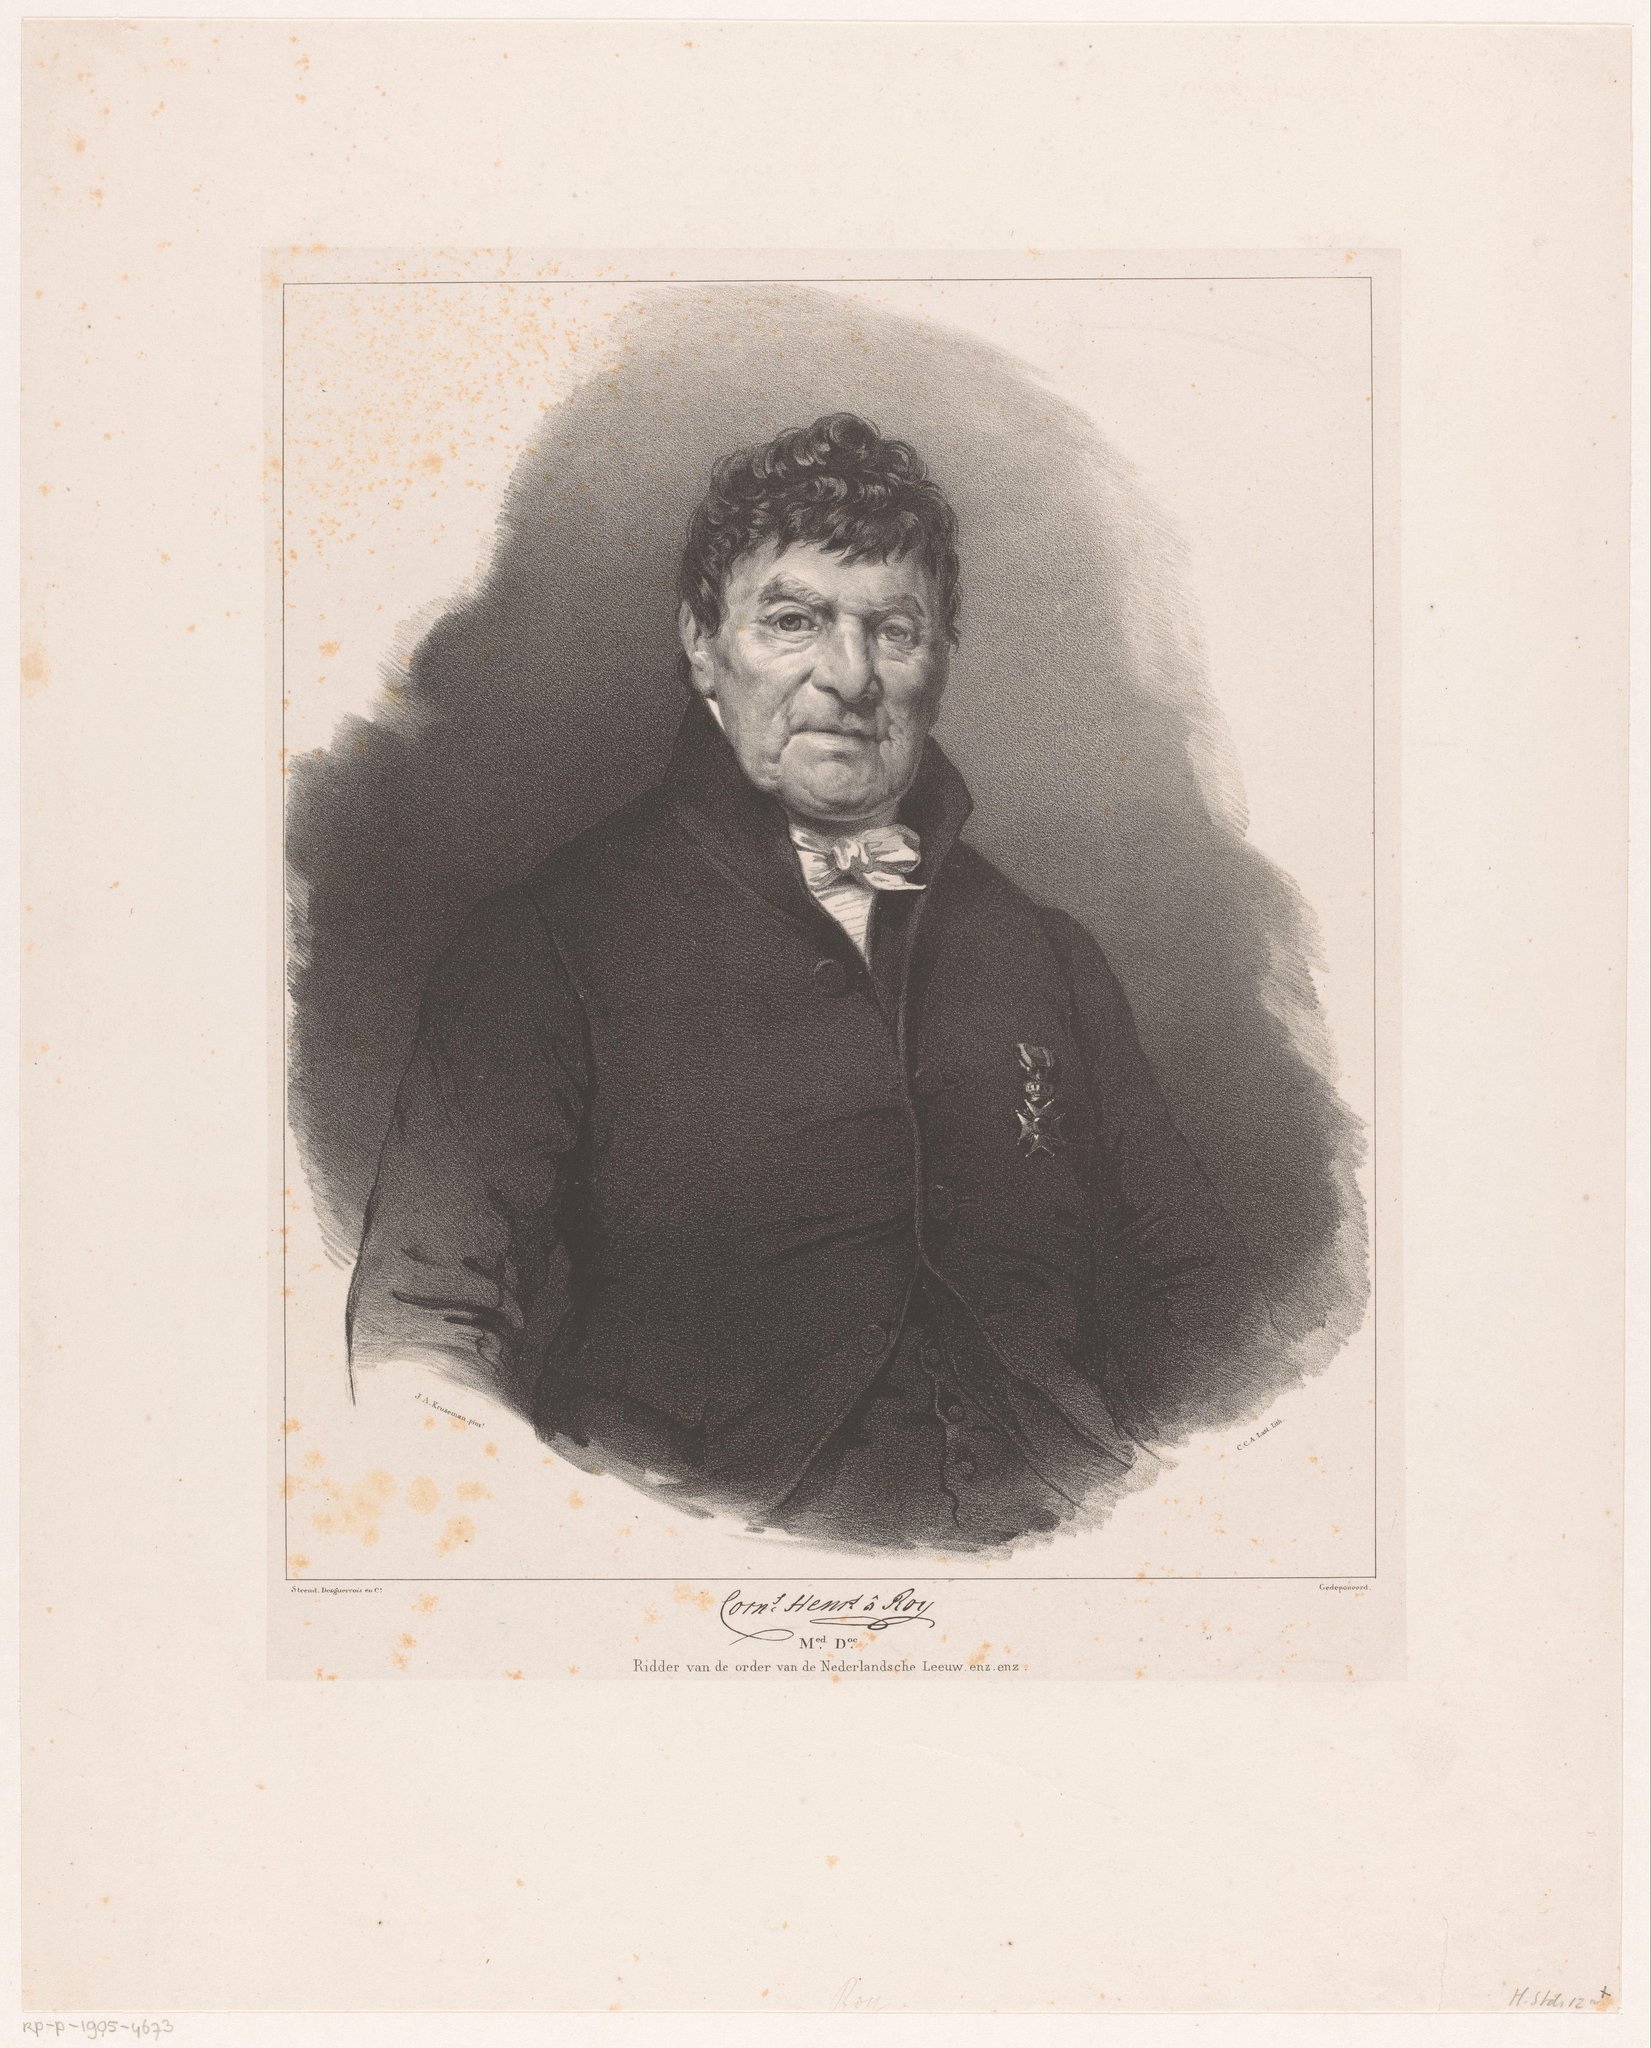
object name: print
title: Portret van Cornelis Henricus à Roy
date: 1833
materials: paper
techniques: lithograph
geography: amsterdam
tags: knighthood order, historical persons (+ (full) bust portrait)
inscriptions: : ‘Gedeponeerd.’, collector's mark: Lugt 2228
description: De geportretteerde draagt een ridderorde op zijn borst. Onder het portret zijn naam en beroep.